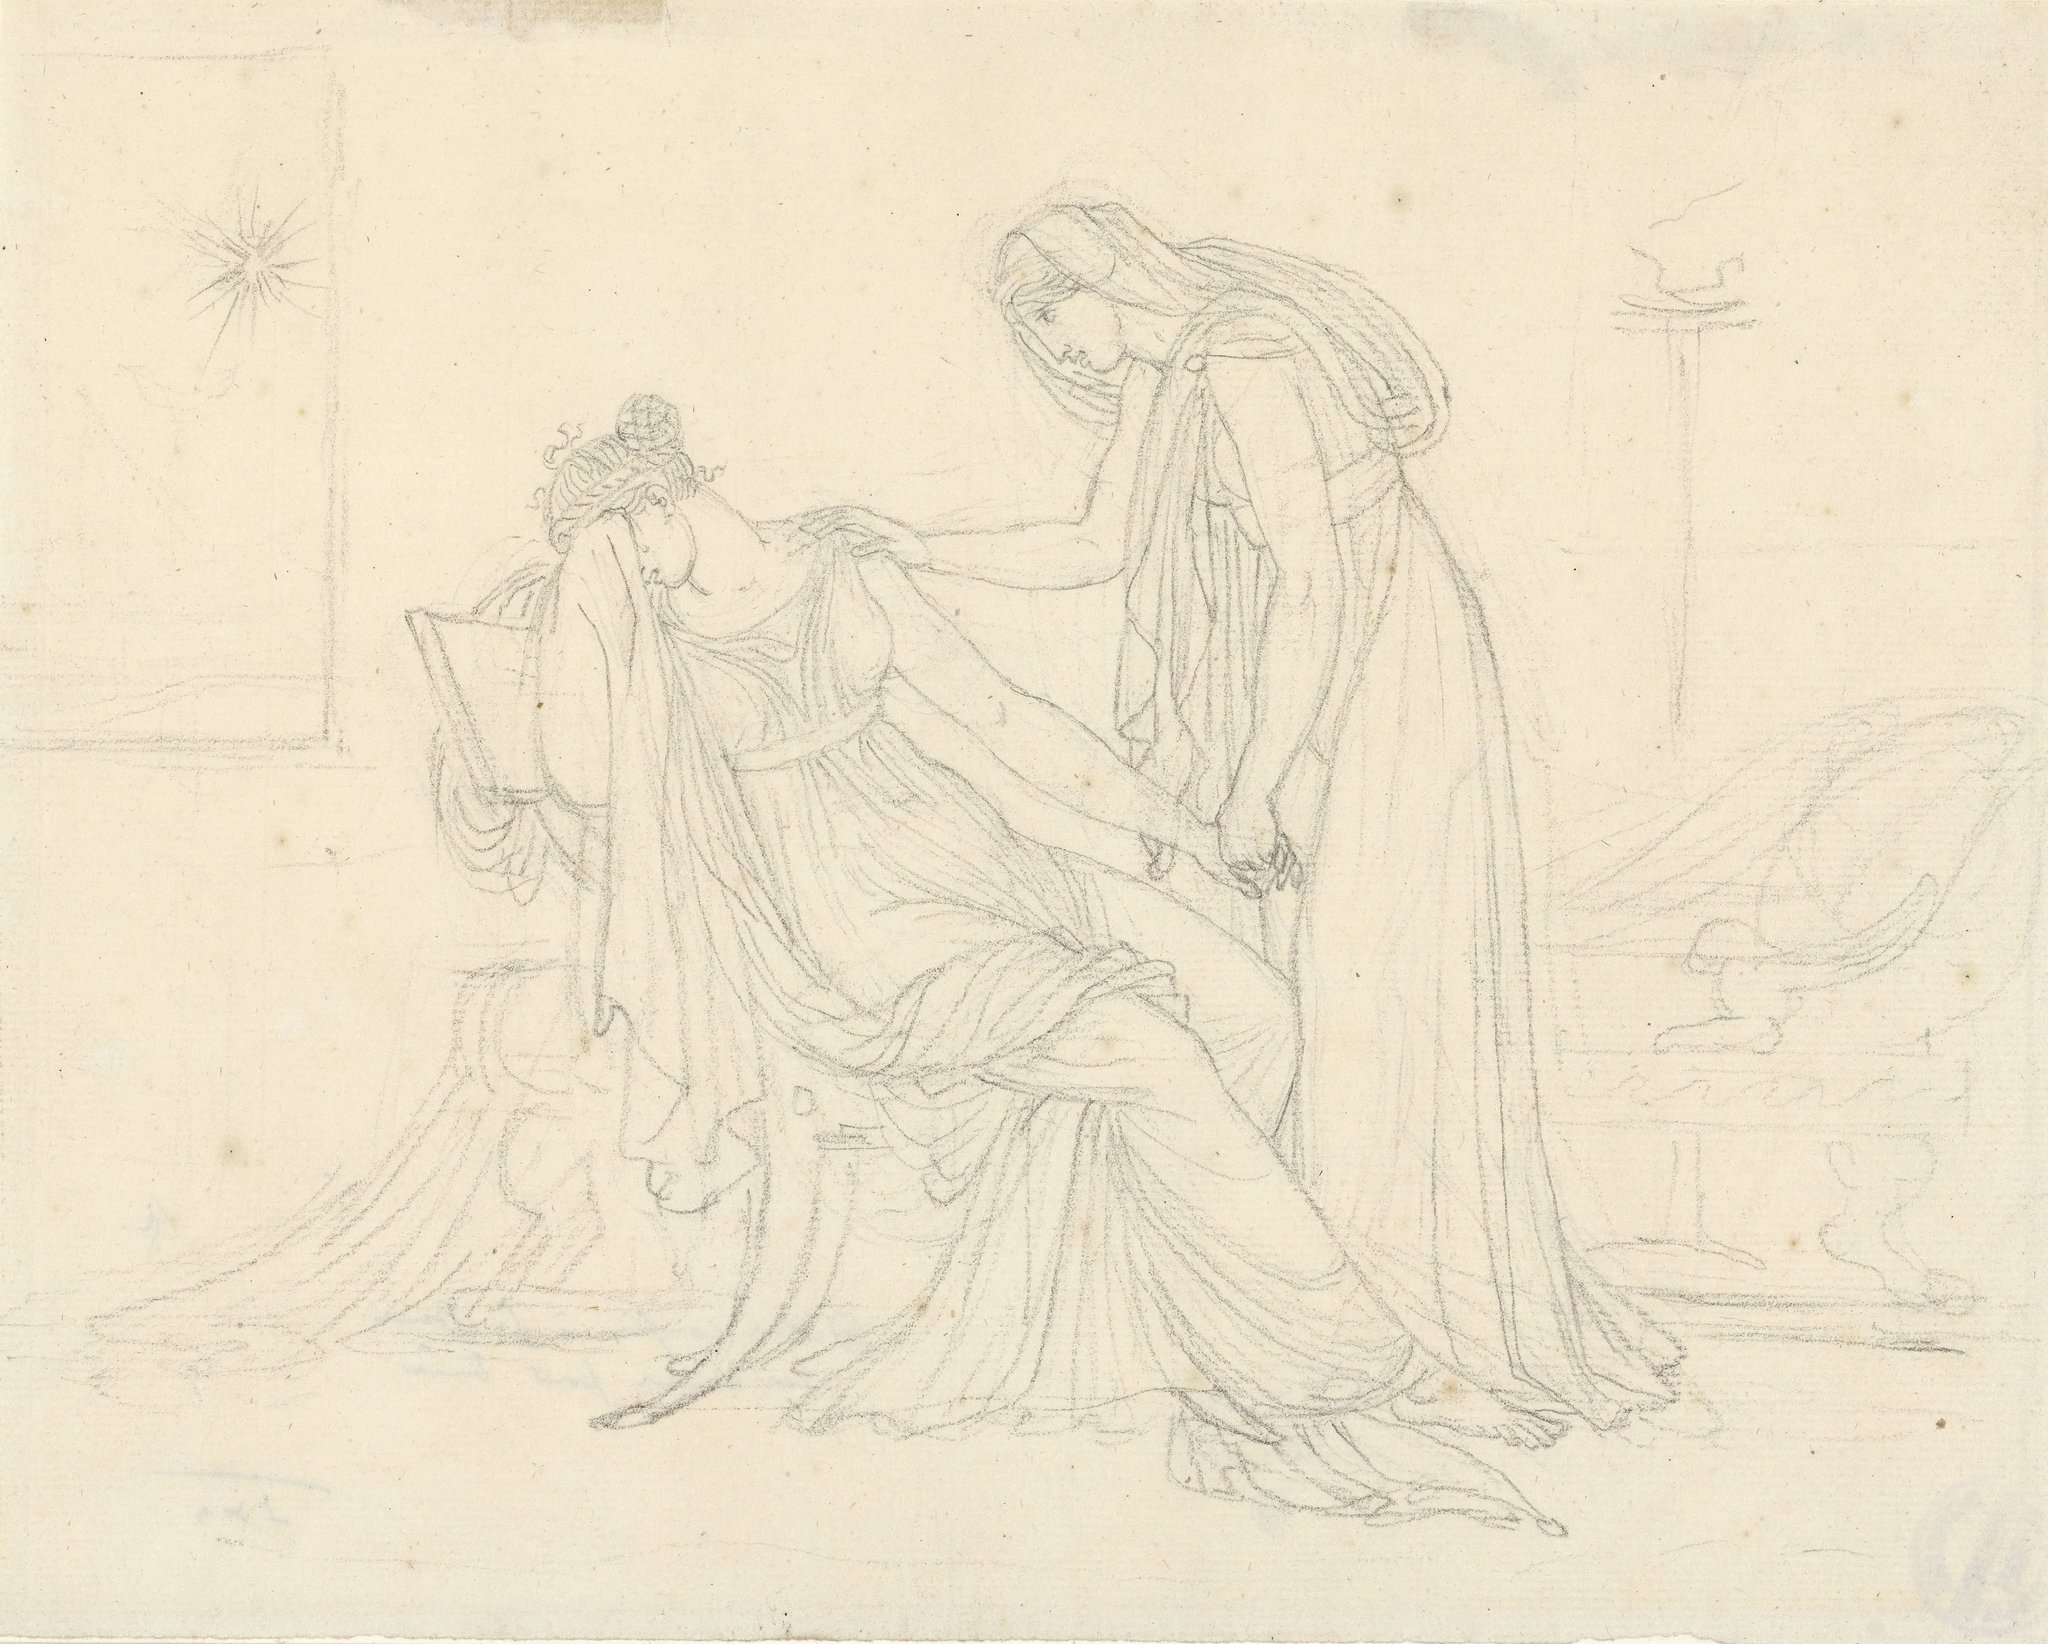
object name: drawing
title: Historie van Dido, vermoedelijk ontwerpen voor illustraties voor de Vergilius-uitgave van Diderot uit 1791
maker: anne-louis girodet-trioson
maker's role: draughtsman, painter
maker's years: 1767-1824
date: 1777-1824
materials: chalk, paper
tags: (story of) dido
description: Serie incompleet: 4 ontwerptekeningen in RPK.